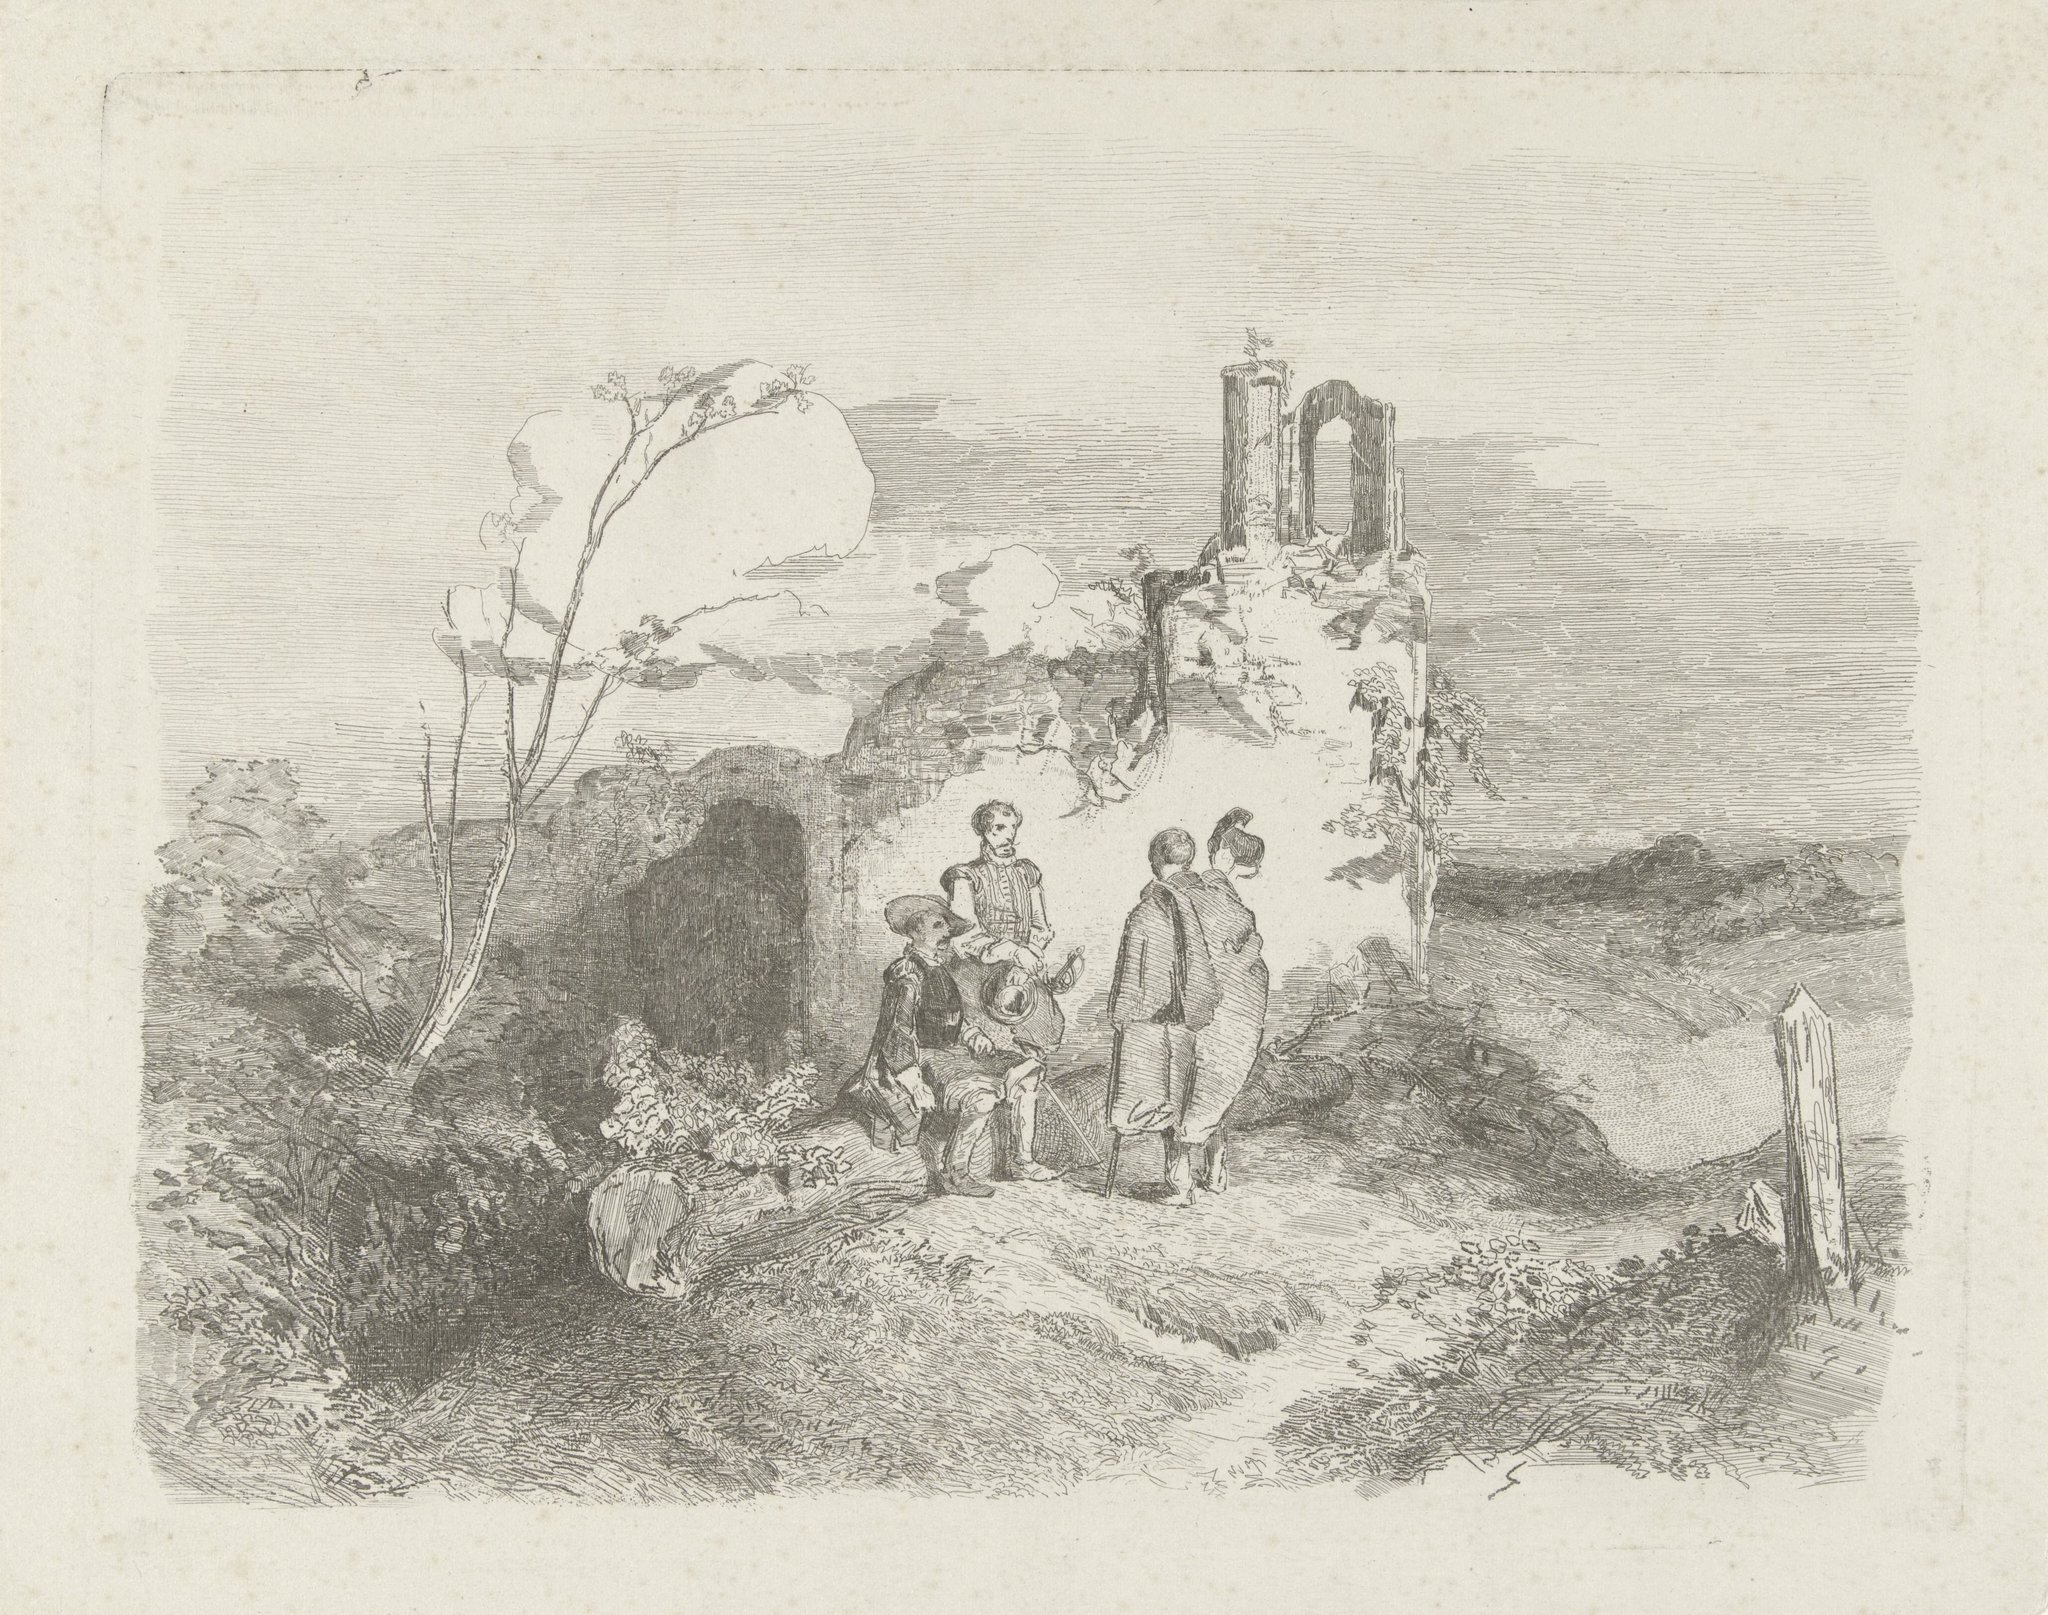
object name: print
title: Mannen bij een ruïne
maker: charles rochussen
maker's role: draughtsman, painter, print maker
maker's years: 1814-1894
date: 1824-1894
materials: paper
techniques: etching, roulette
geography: netherlands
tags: low hill country, meeting, ruin of a dwelling, house, castle, etc.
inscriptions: collector's mark: Lugt 2228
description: In een glooiend landschap staan drie mannen bij een ruïne. Een van de mannen lijkt de andere twee te begroeten met zijn hoed.